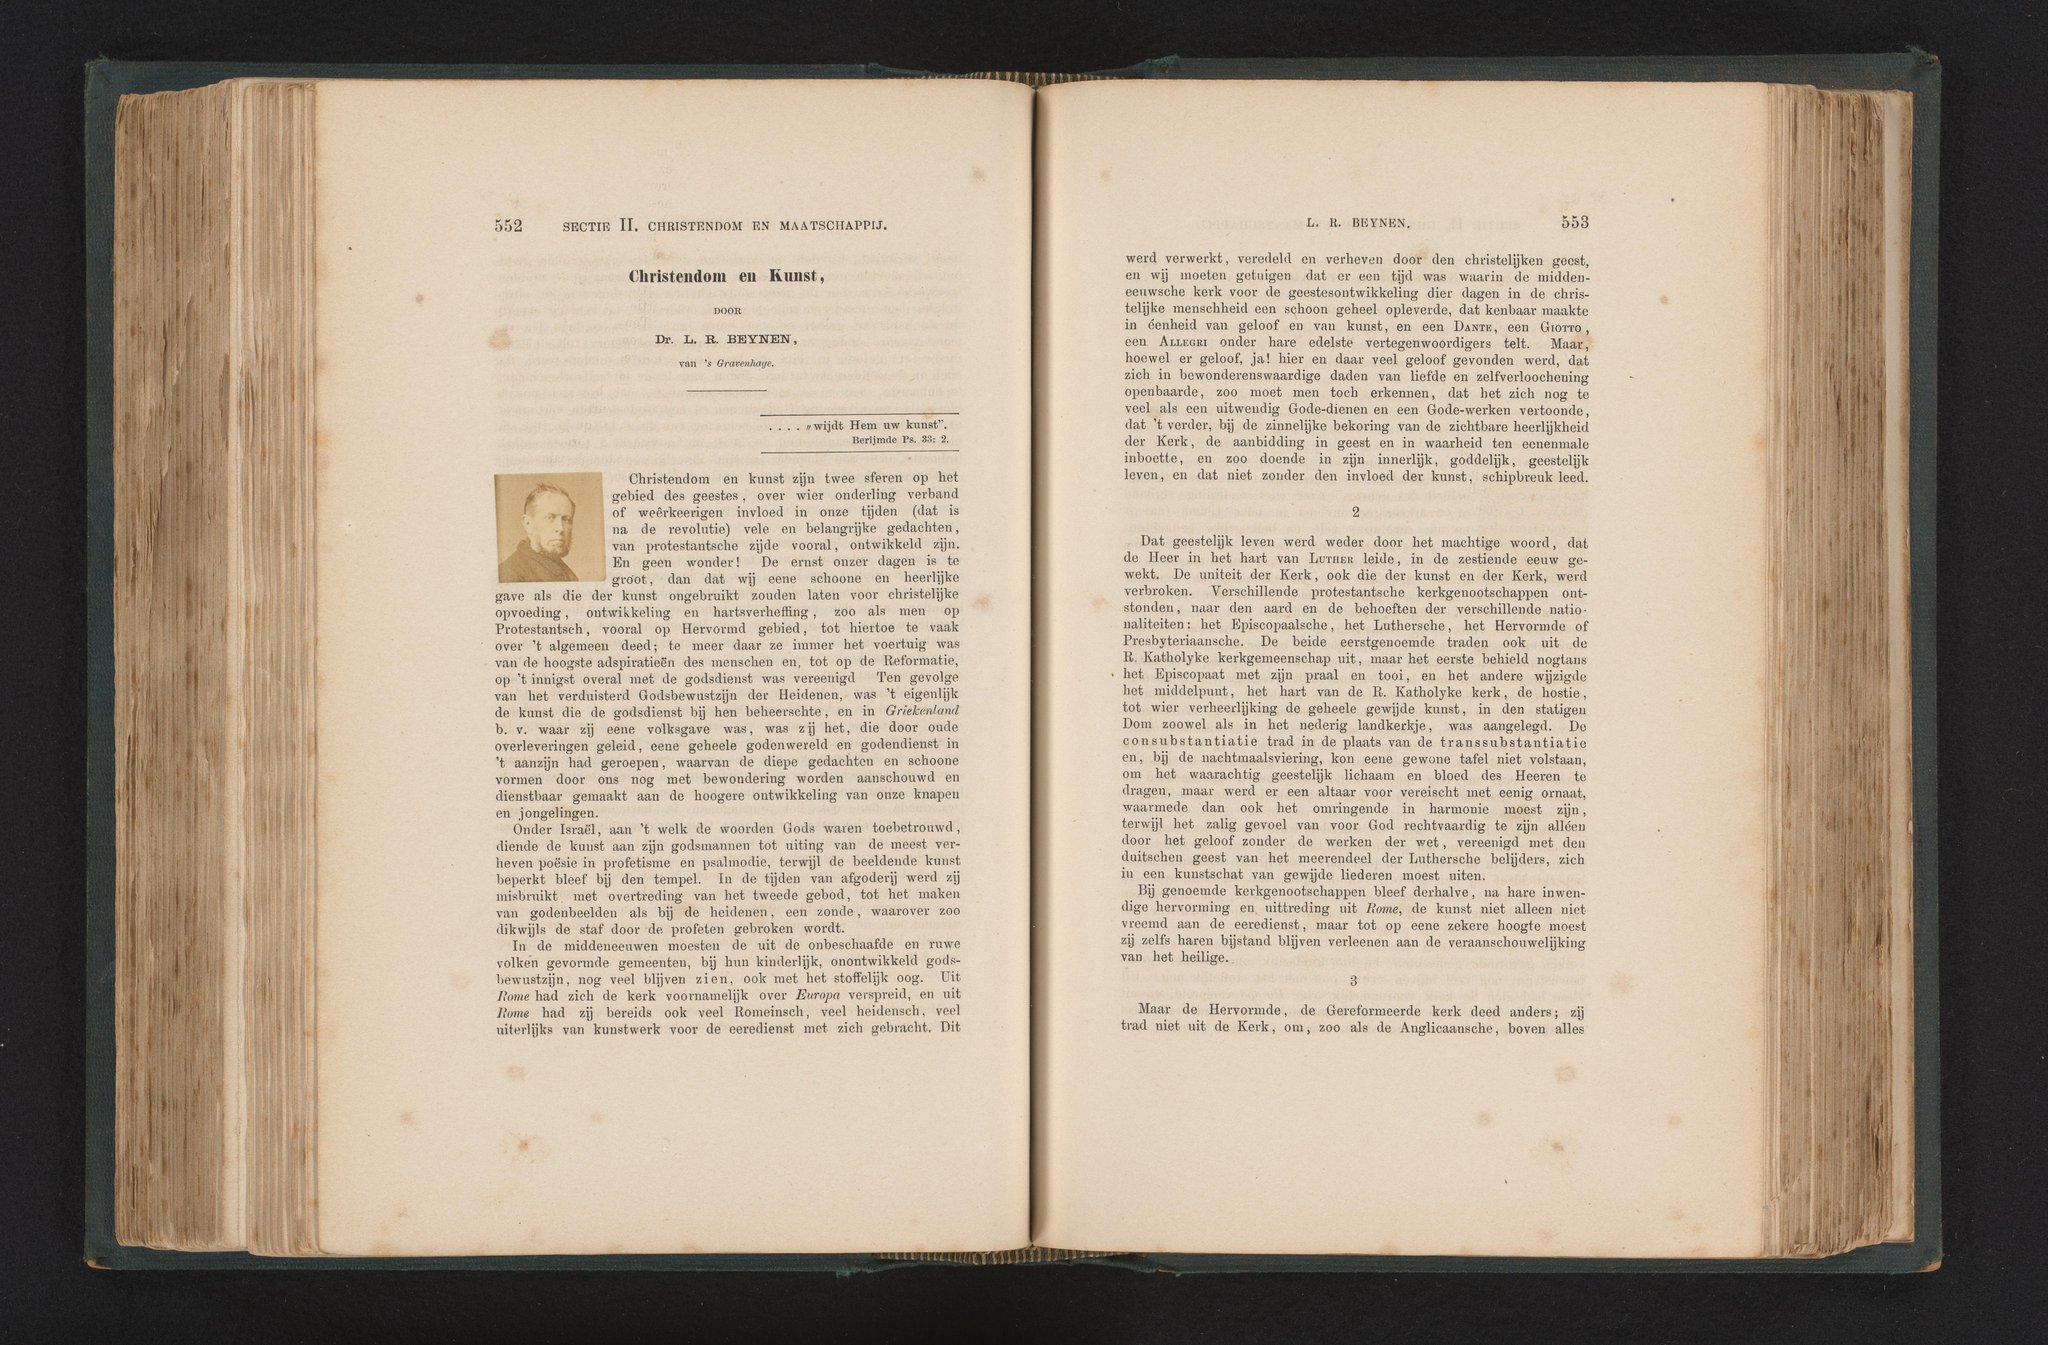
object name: photograph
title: Portret van L.R. Beynen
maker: Anonymous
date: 1855-1867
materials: paper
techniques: albumen print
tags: the hague, laurens reinhart beijnen, historical persons